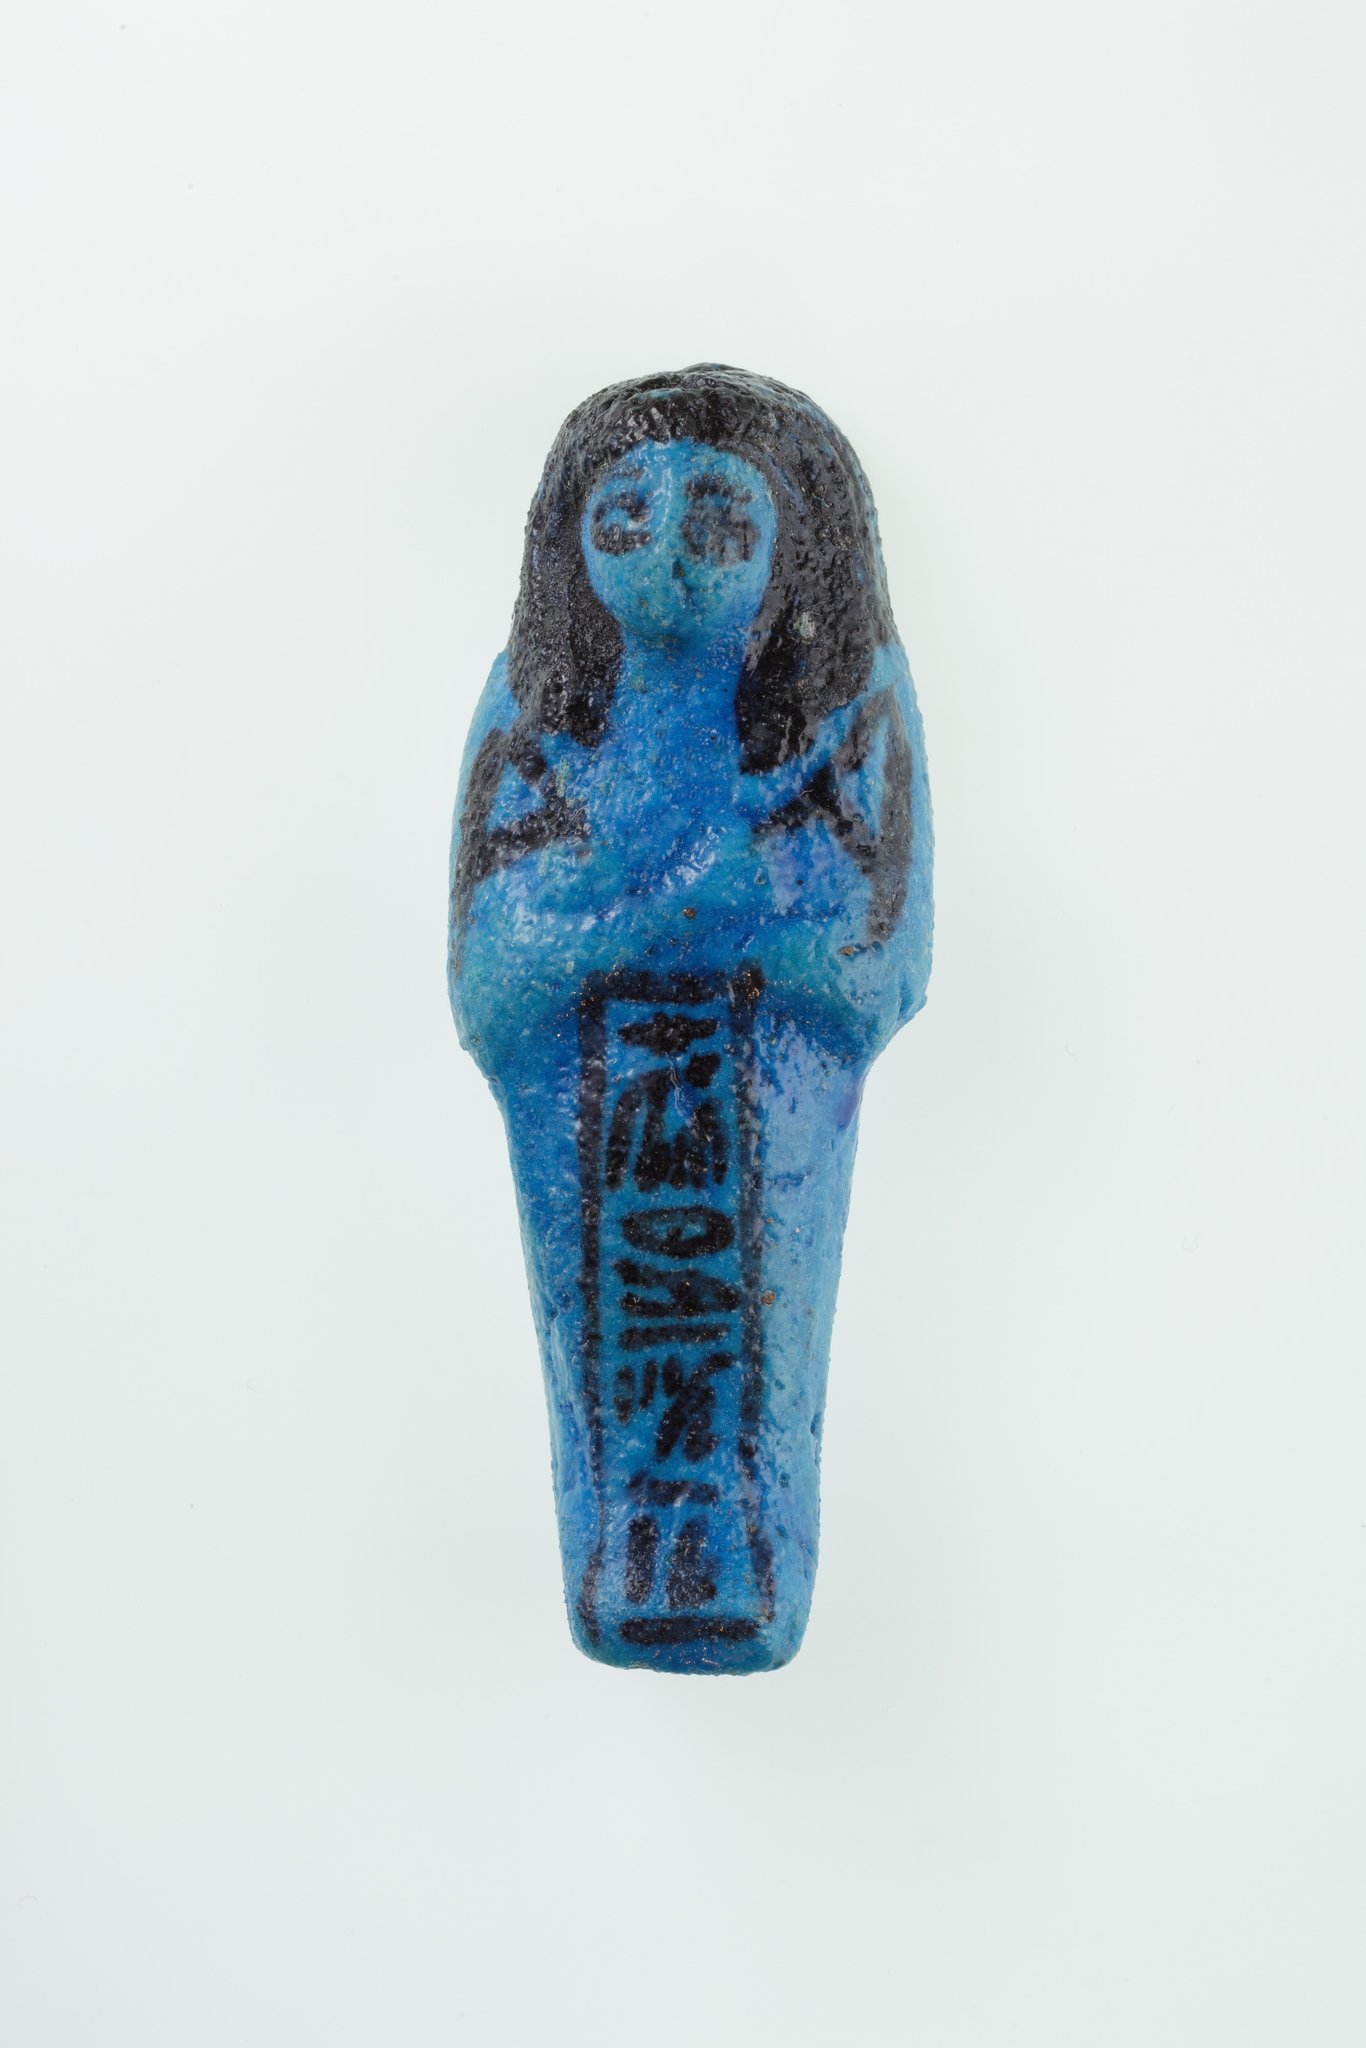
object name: shabti, worker, nauny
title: Worker Shabti of Nauny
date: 1050 BCE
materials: faience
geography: egypt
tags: hieroglyphs